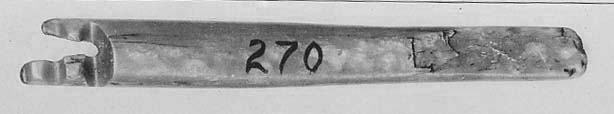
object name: knife sharpener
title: Knife-sharpener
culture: north american, alaskan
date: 1902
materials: jade